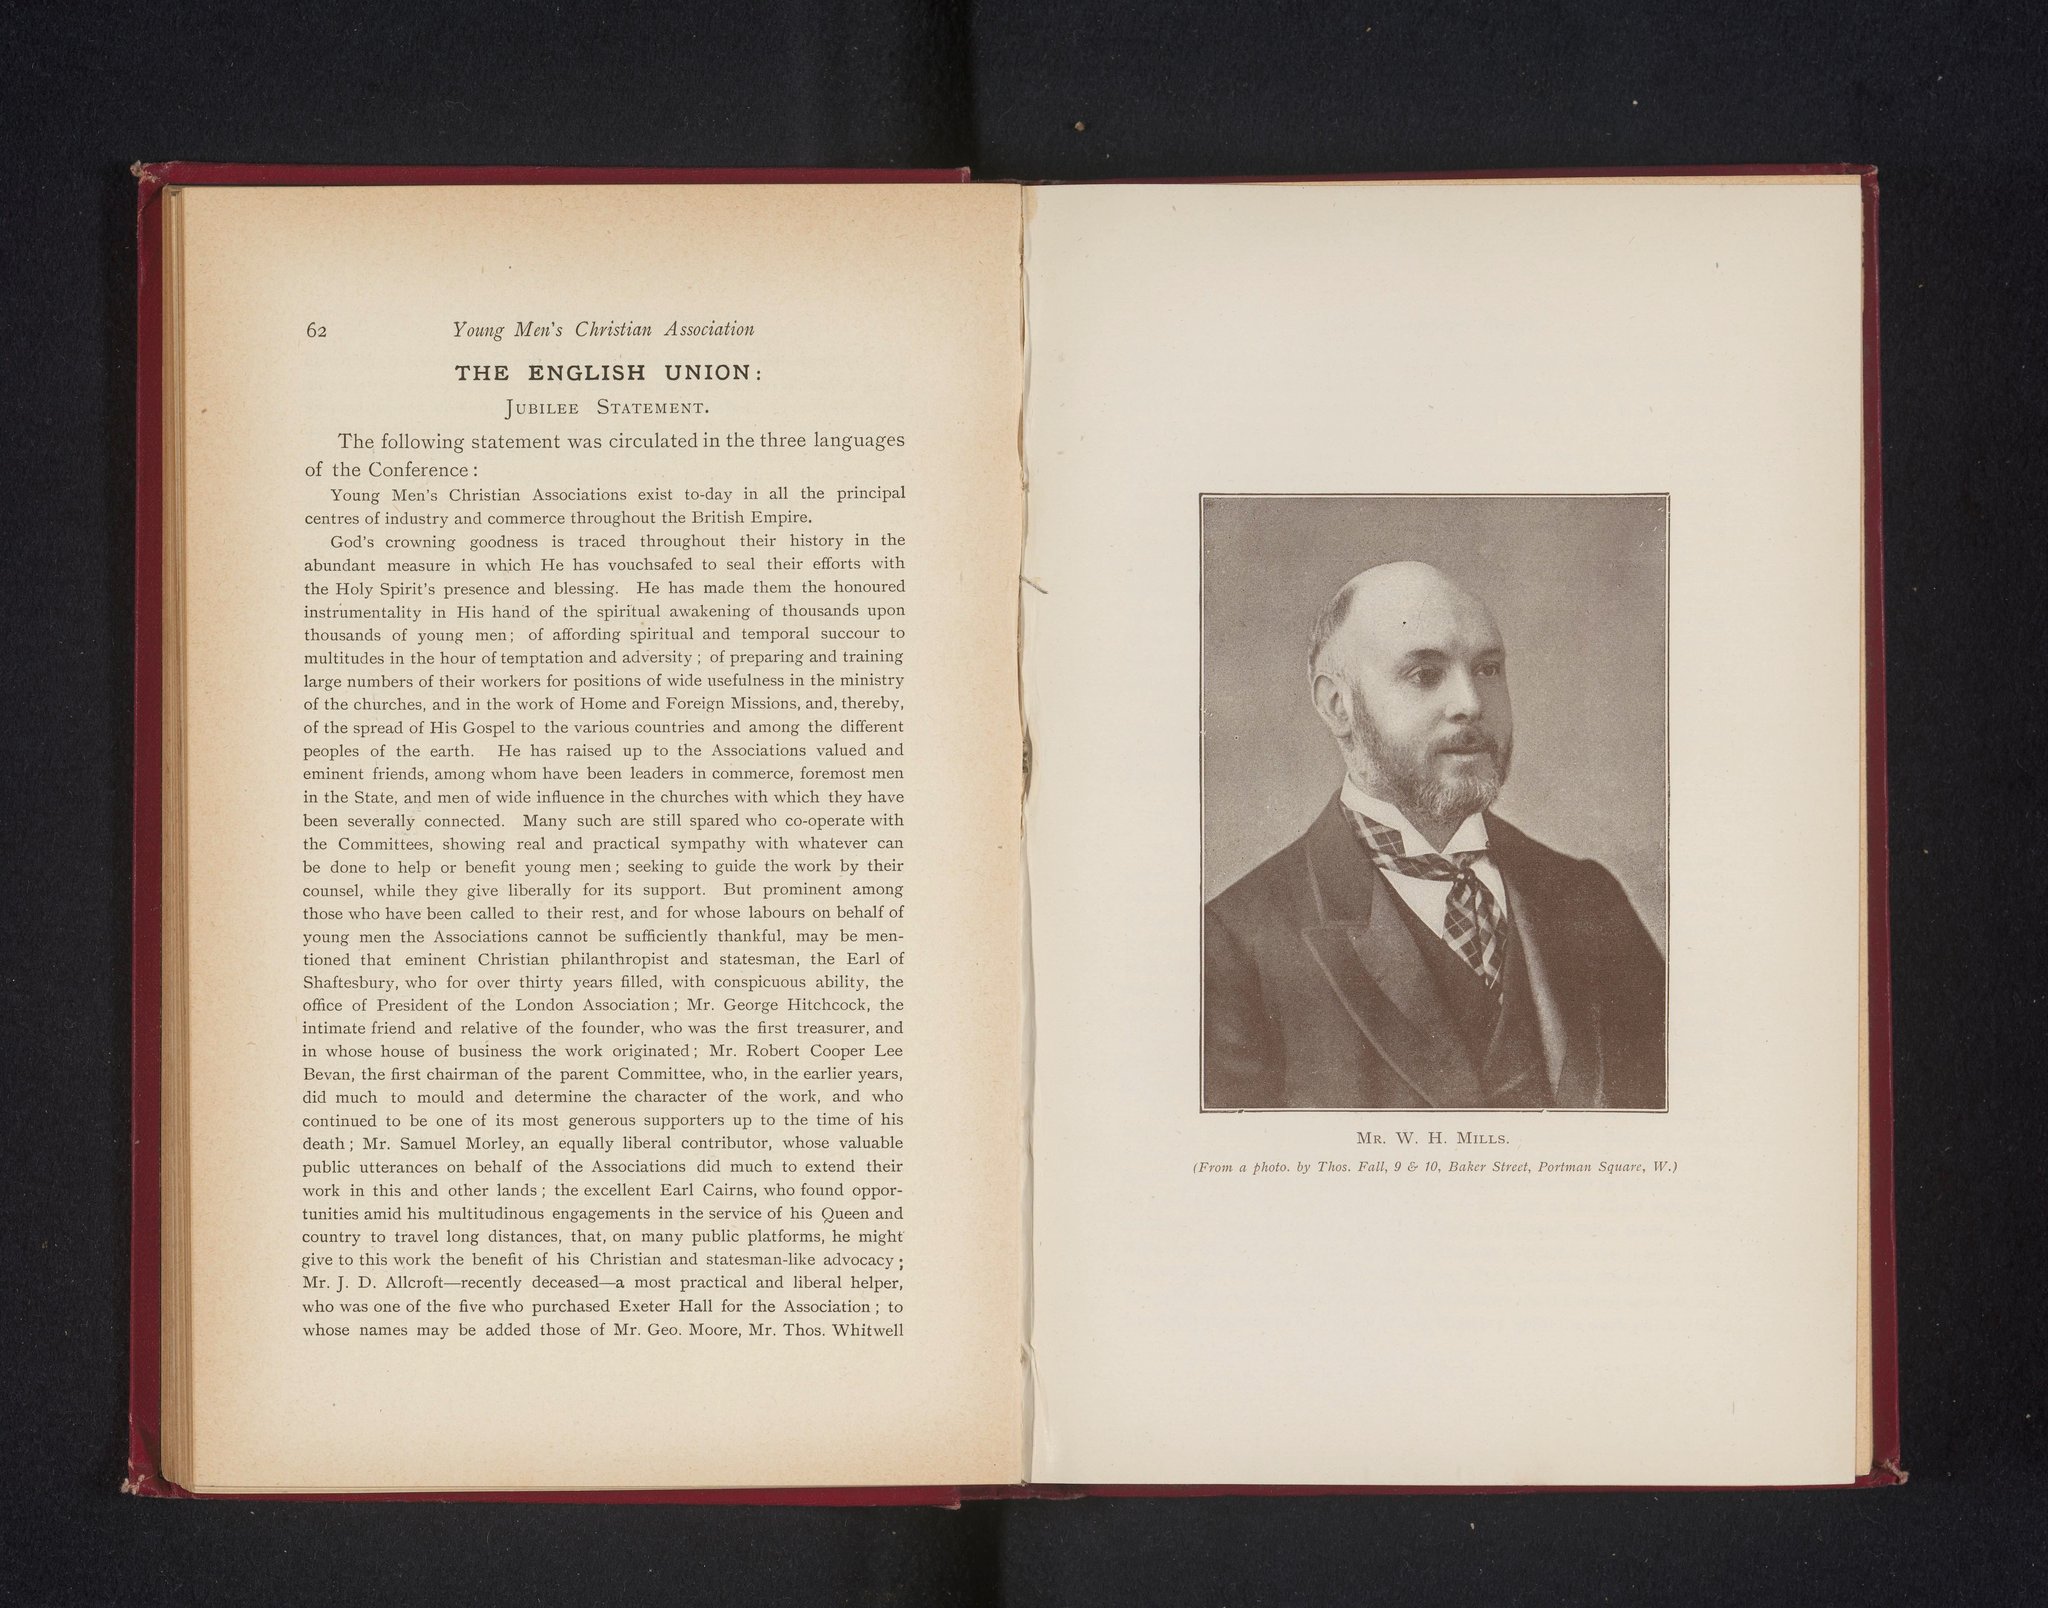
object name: page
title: Portret van W.H. Mills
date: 1890-1895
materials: paper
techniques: autotype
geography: london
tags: historical persons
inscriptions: inscription: ‘(From a photo. by Thos. Fall, 9 & 10, Baker Street, Portman Square, W.)’